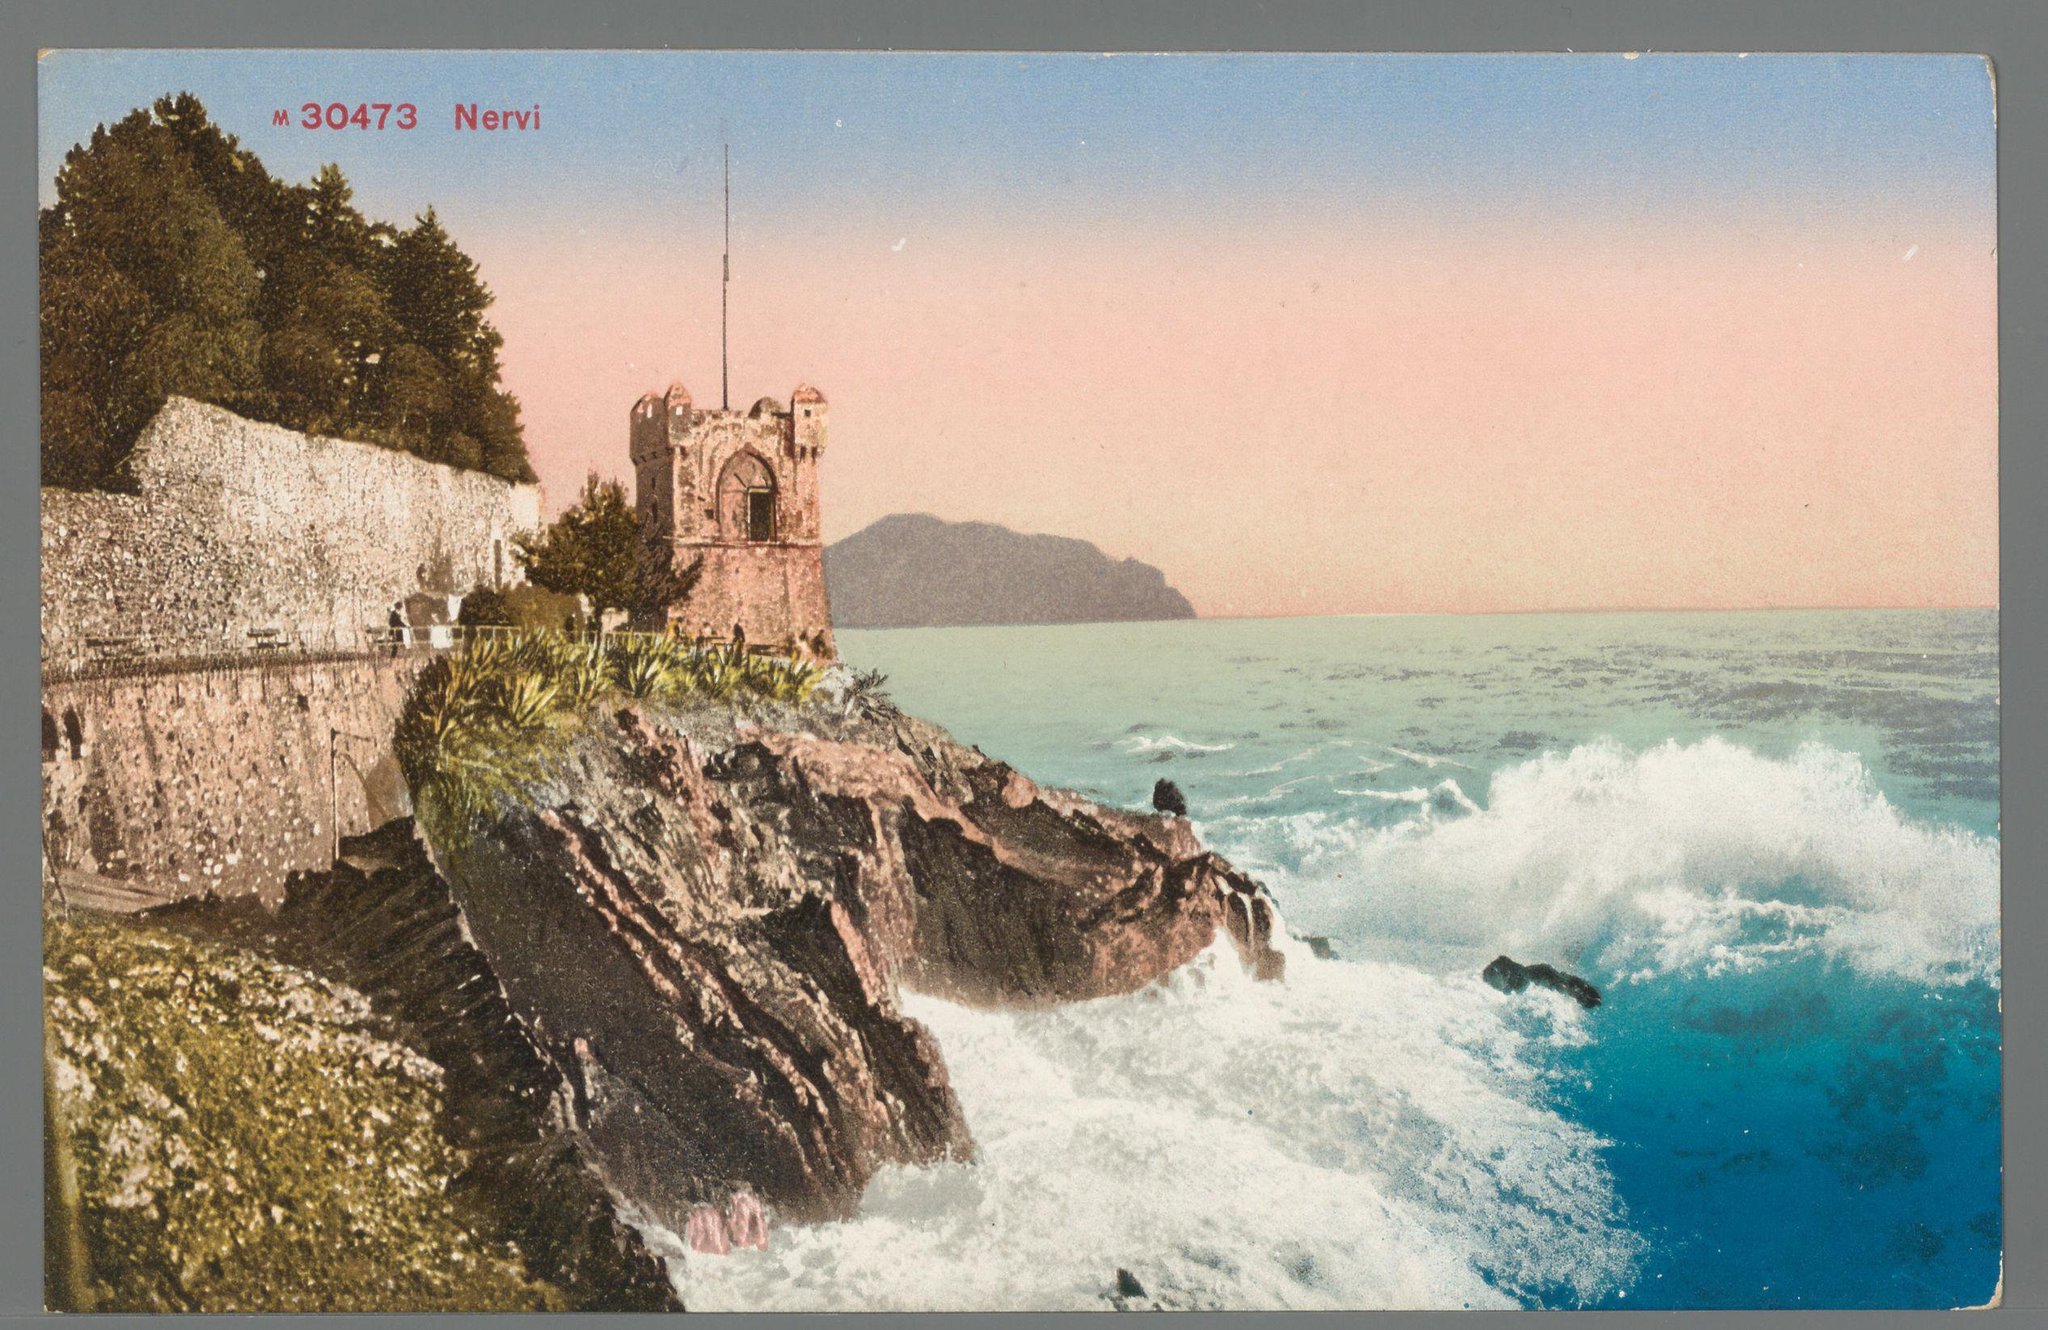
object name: ansichtkaart, prentbriefkaart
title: Nervi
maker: Anonymous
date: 1905-1930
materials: cardboard, photographic process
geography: zurich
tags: rocky coast, permanent fortifications